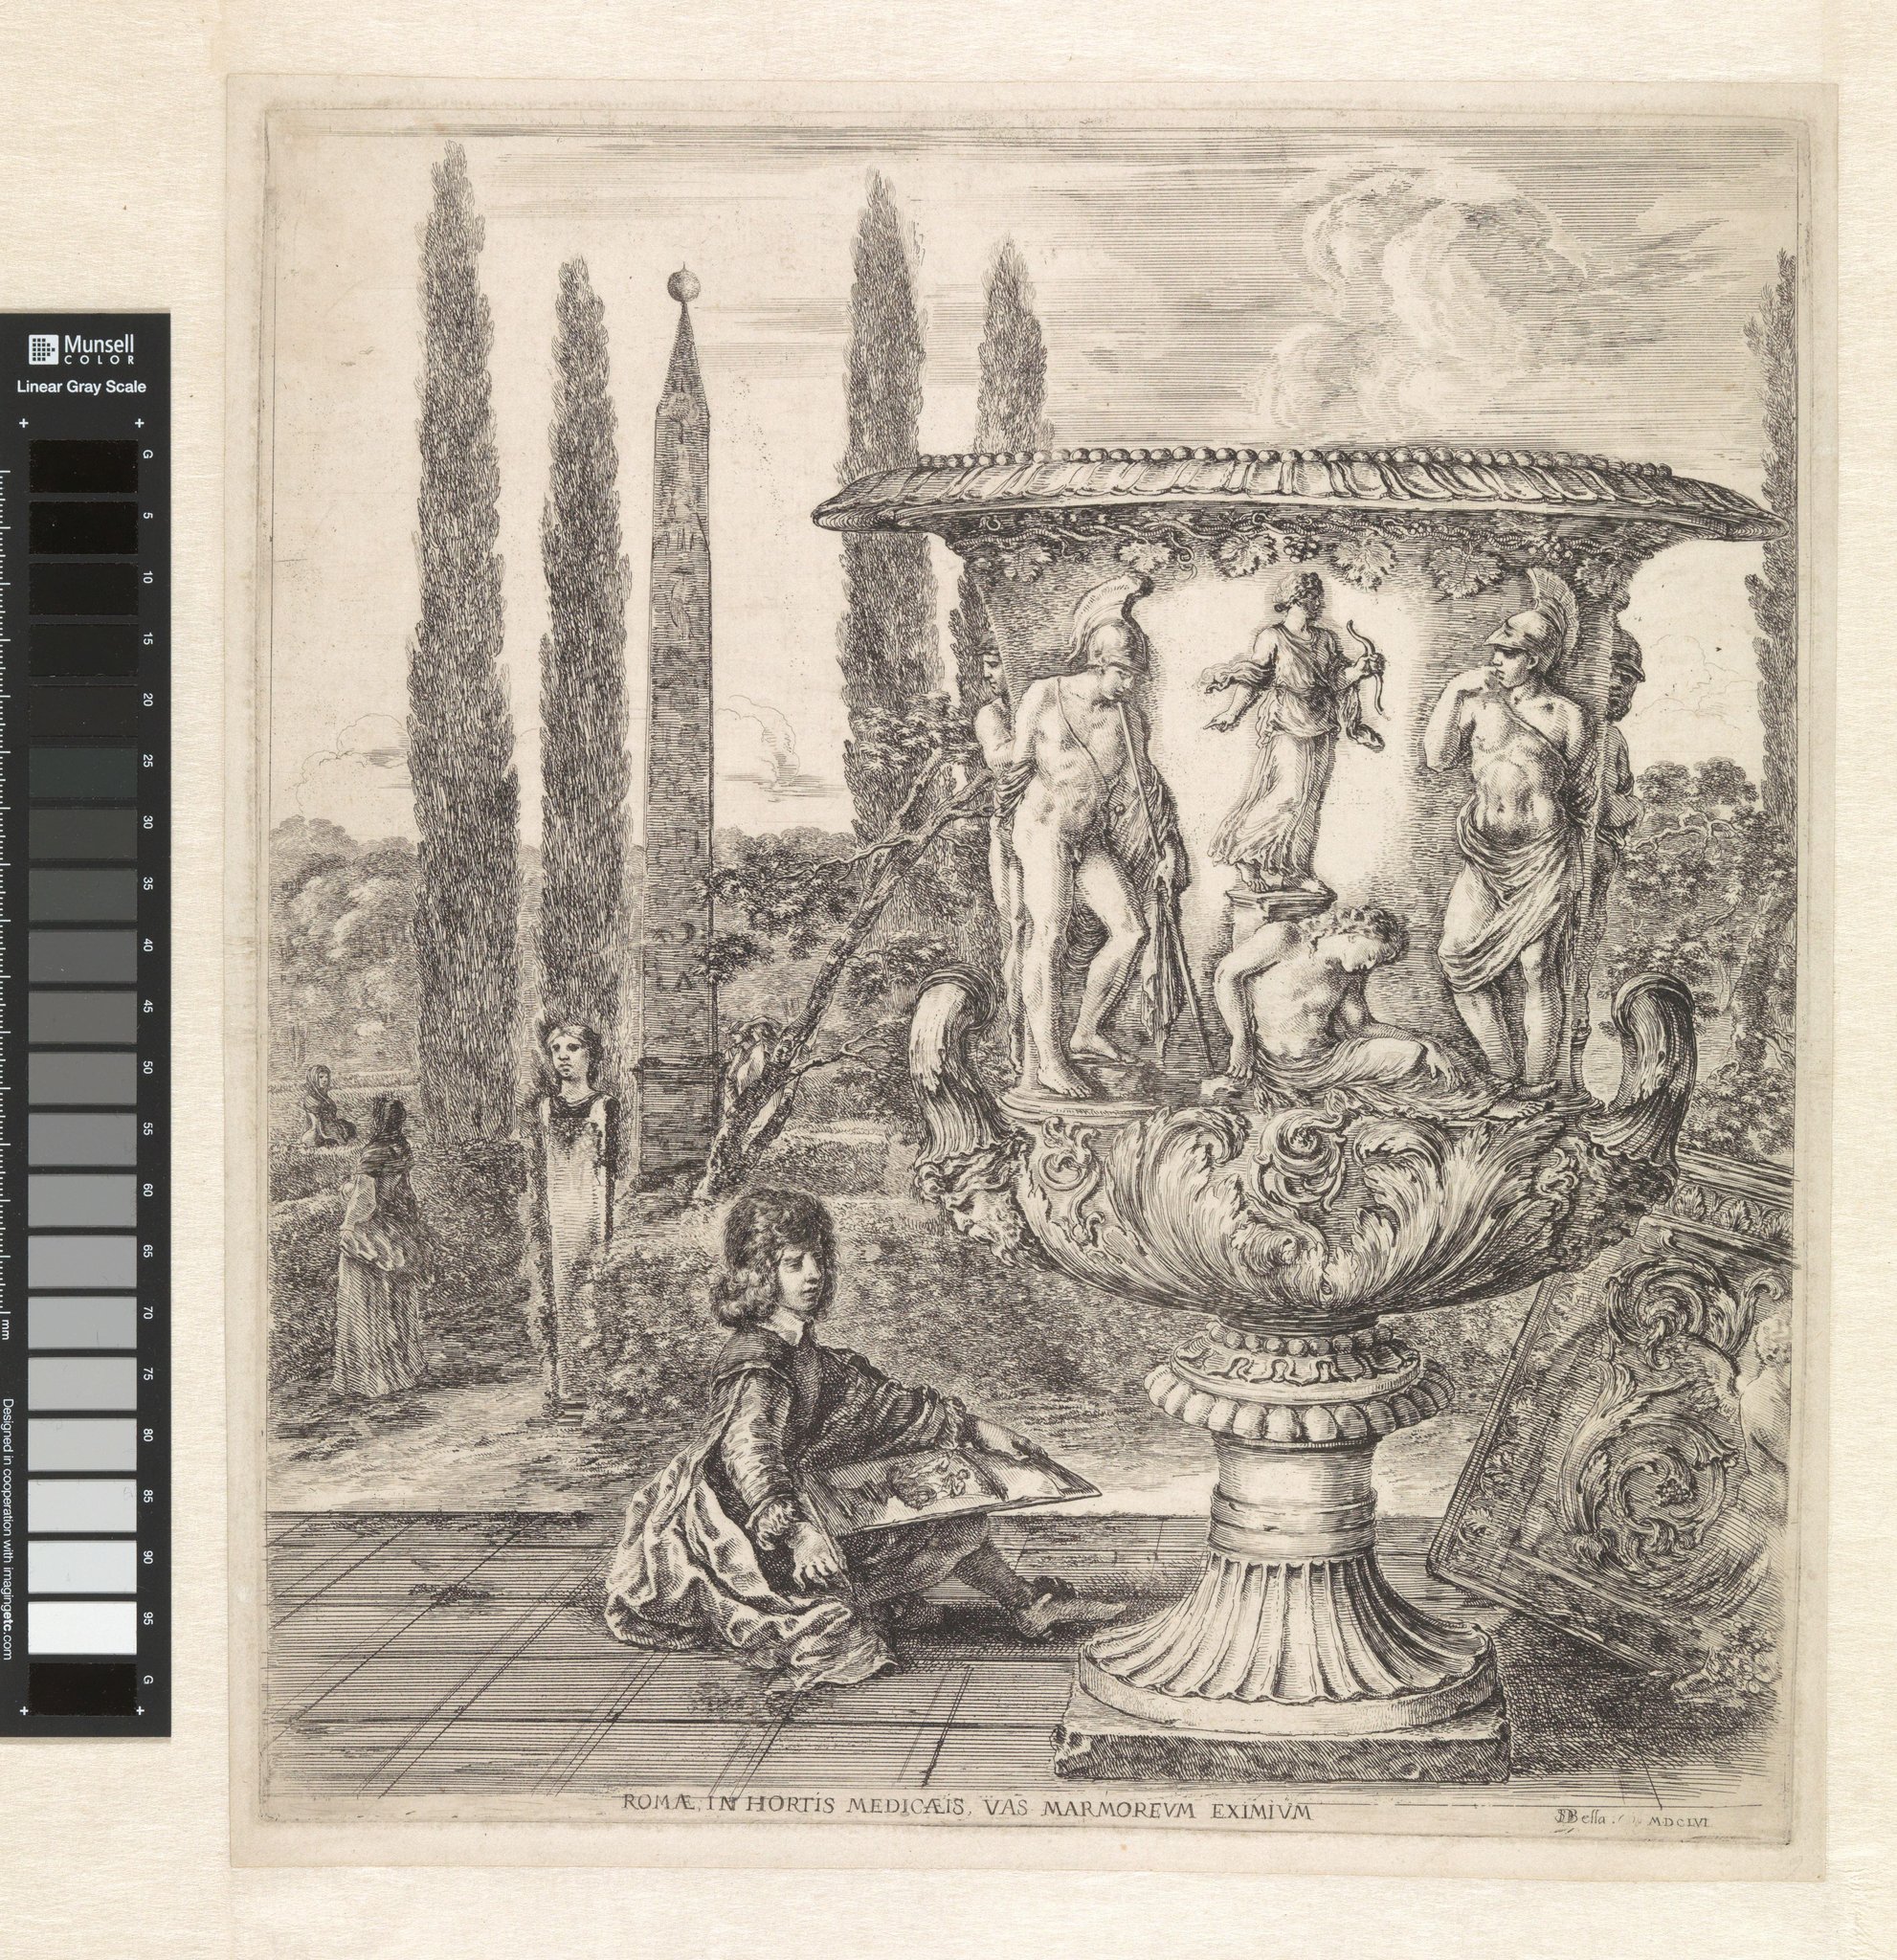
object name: print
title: Cosimo III de Medici in the Garden of the Villa Medici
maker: stefano della bella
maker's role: draughtsman, print maker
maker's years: 1610-1664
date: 1656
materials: paper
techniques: etching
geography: italy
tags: cosimo iii de' medici, obelisks (garden ornaments), garden, container of stone: stone vase, draughtsman studying classical remains - cc - out of doors, garden vase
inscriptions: collector's mark: Lugt 2760, collector's mark: Lugt 2228, watermark: ‘ster in cirkel’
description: Stefano Della Bella portrayed Prince Cosimo III de Medici while he closely studies a vase larger than himself. In 1656 Cosimo was fourteen years old and blissfully ignorant of the eventful life that lay ahead of him as a scion of the powerful Medici family. Art would alwayshold a special place for him. The Greek vase from the first century was a veritable showpiece in the garden of the Villa Medici.